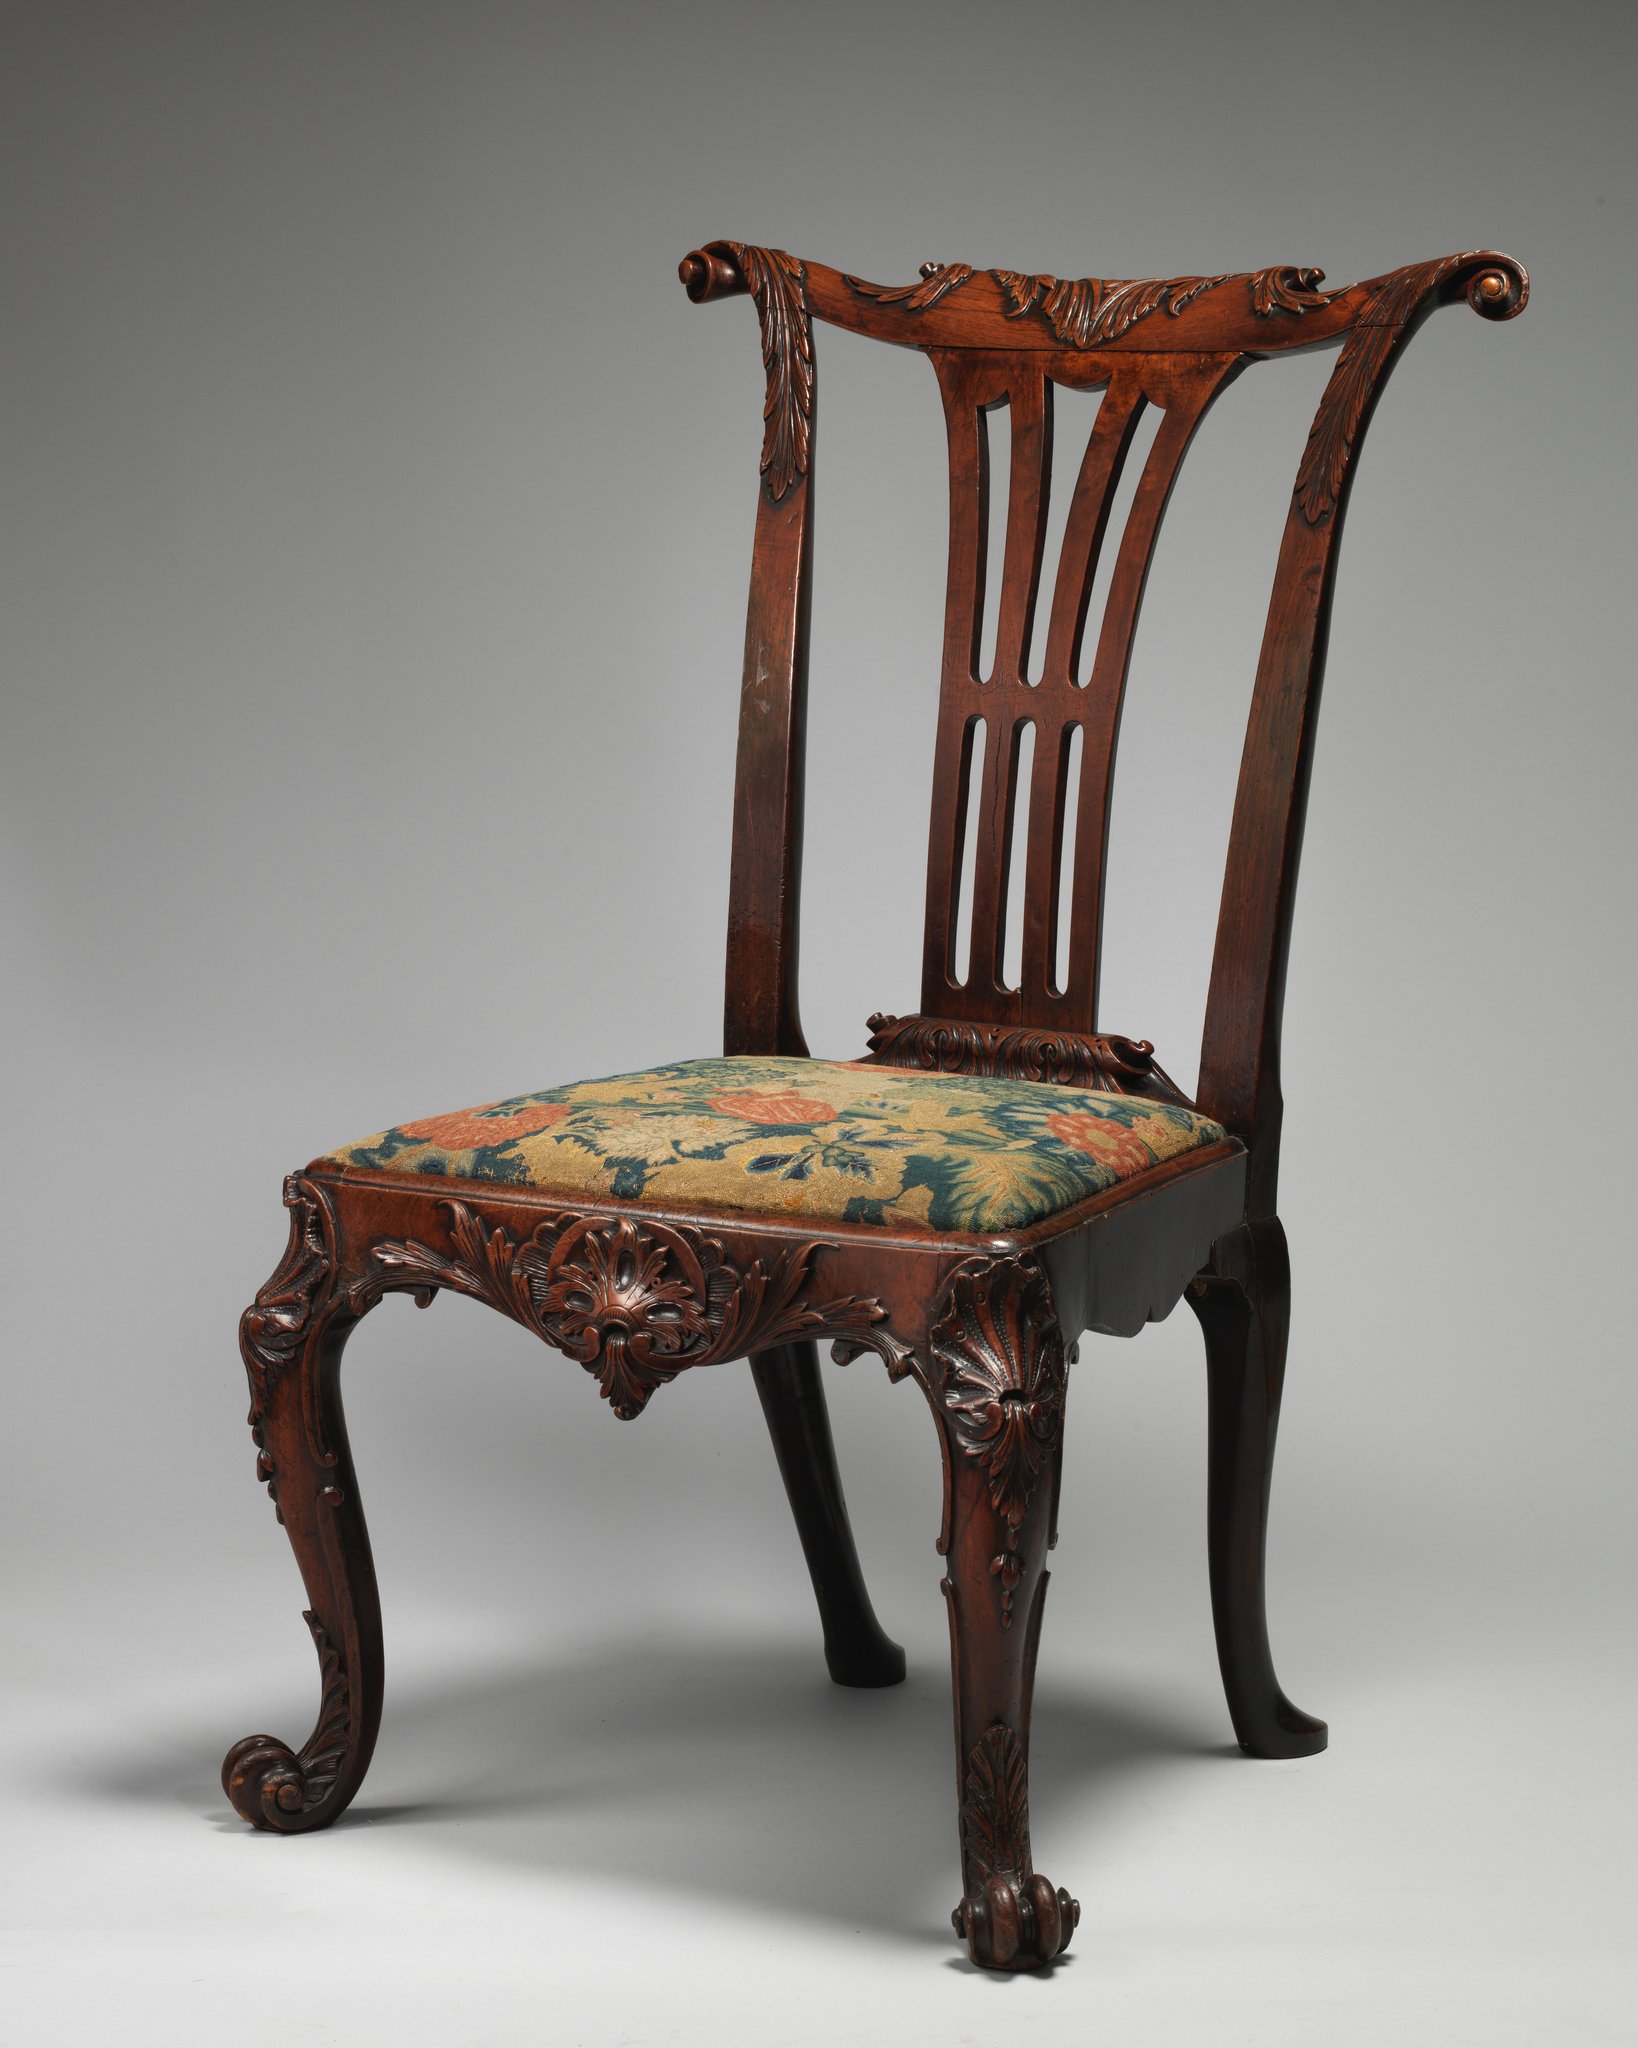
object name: side chair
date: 1740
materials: wood